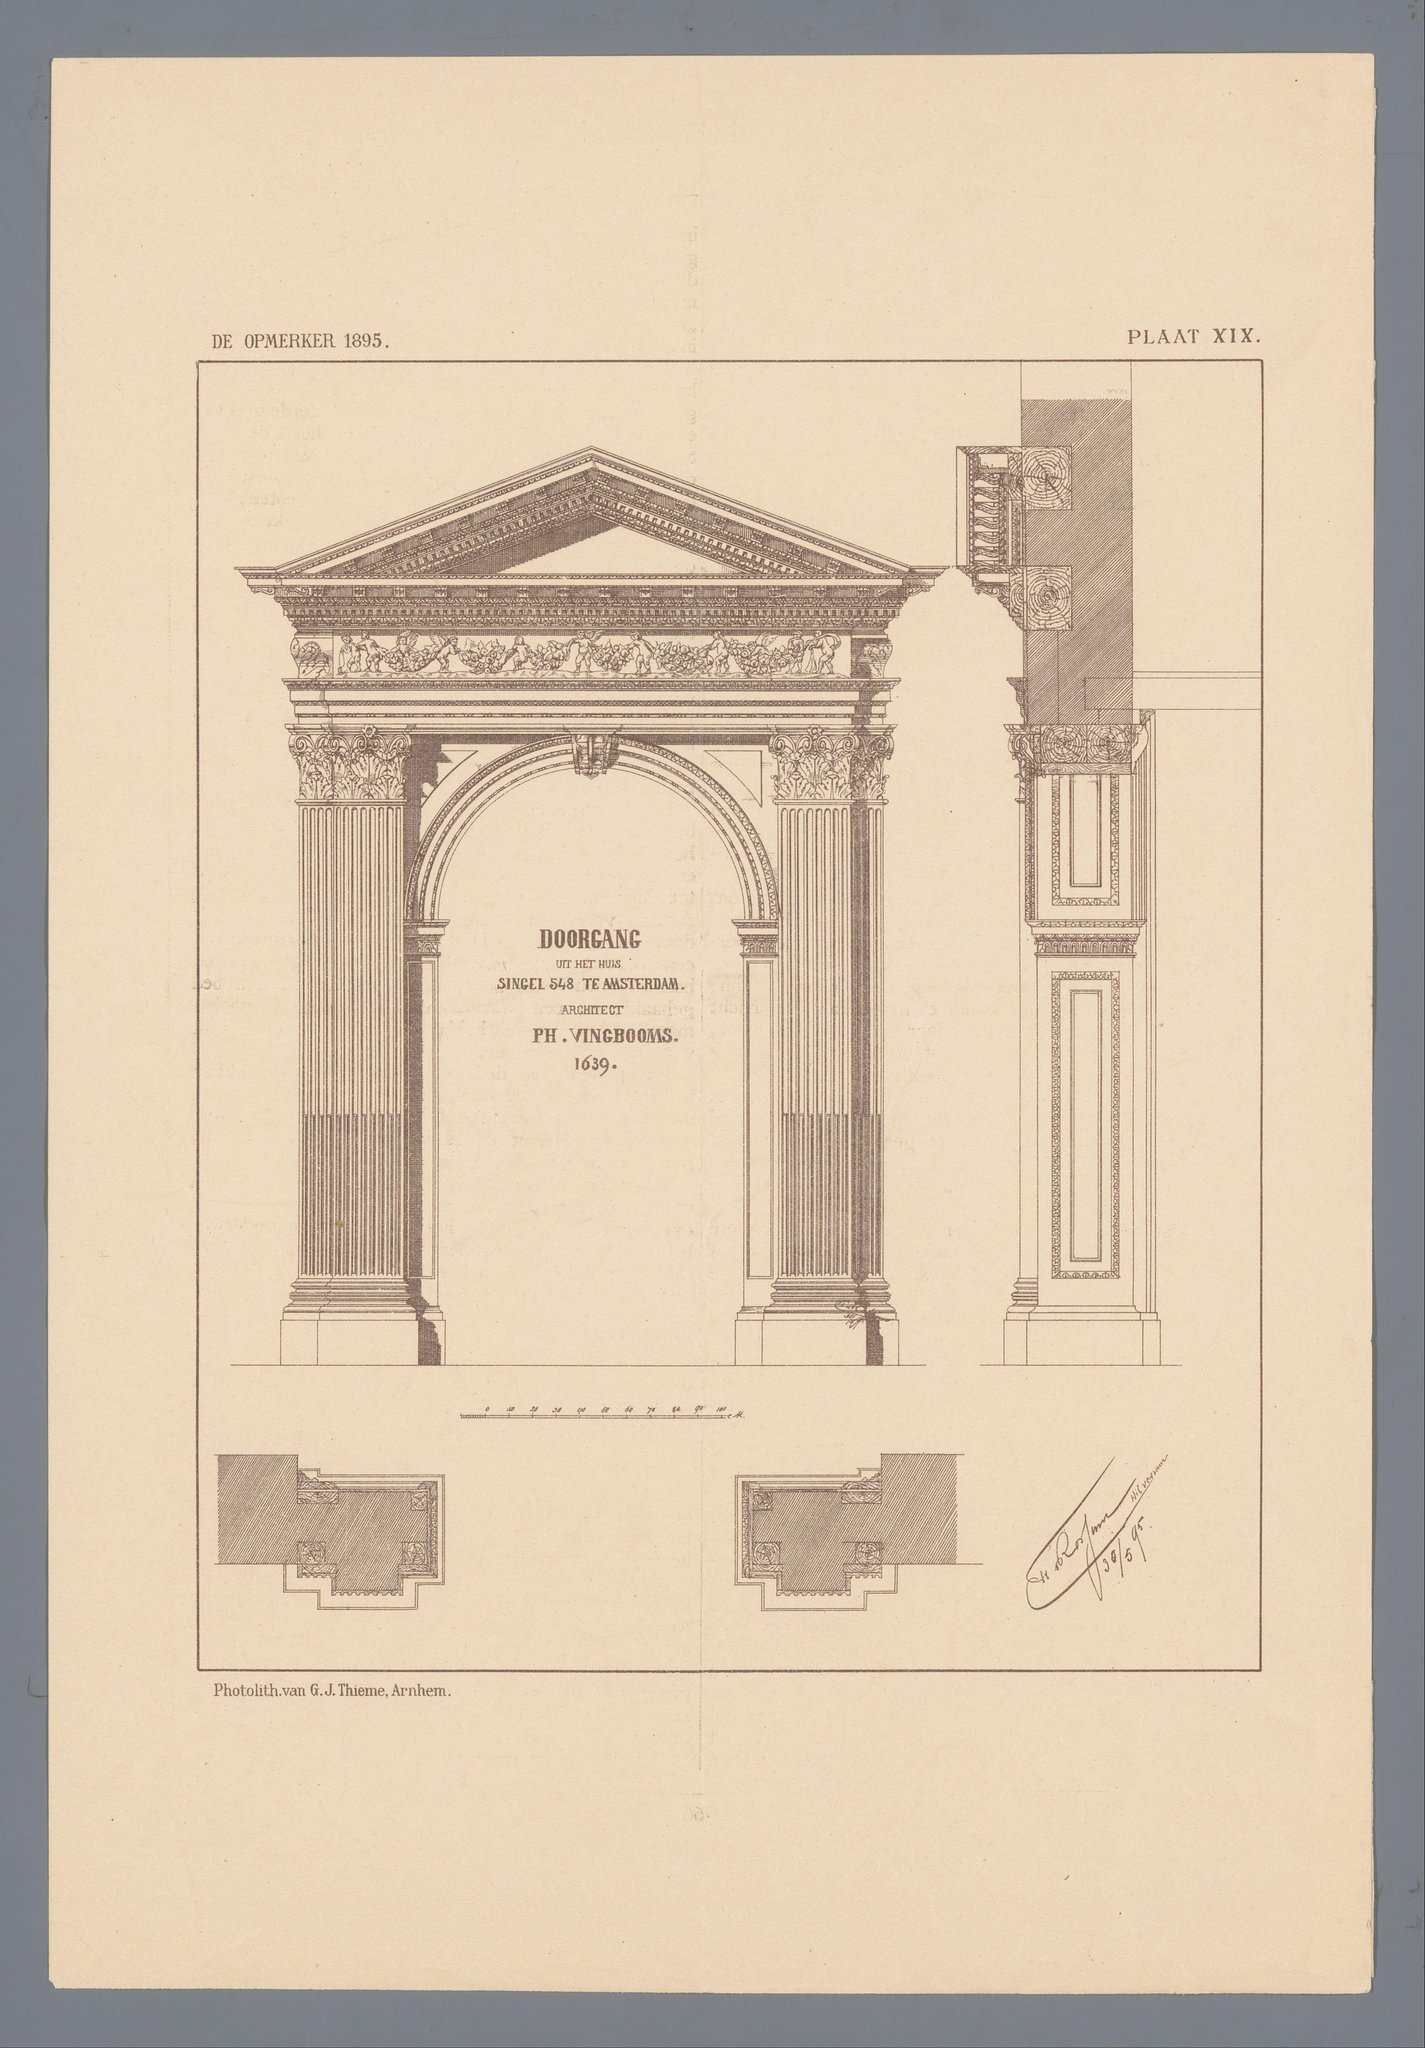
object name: photomechanical print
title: Doorgang uit het huis Singel 548 te Amsterdam. Architect Ph. Vinbooms. 1639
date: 1895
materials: paper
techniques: photolithography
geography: arnhem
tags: gate, entrance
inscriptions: date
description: Prent uit: De Amsterdammer 30 (1895), p. 363.